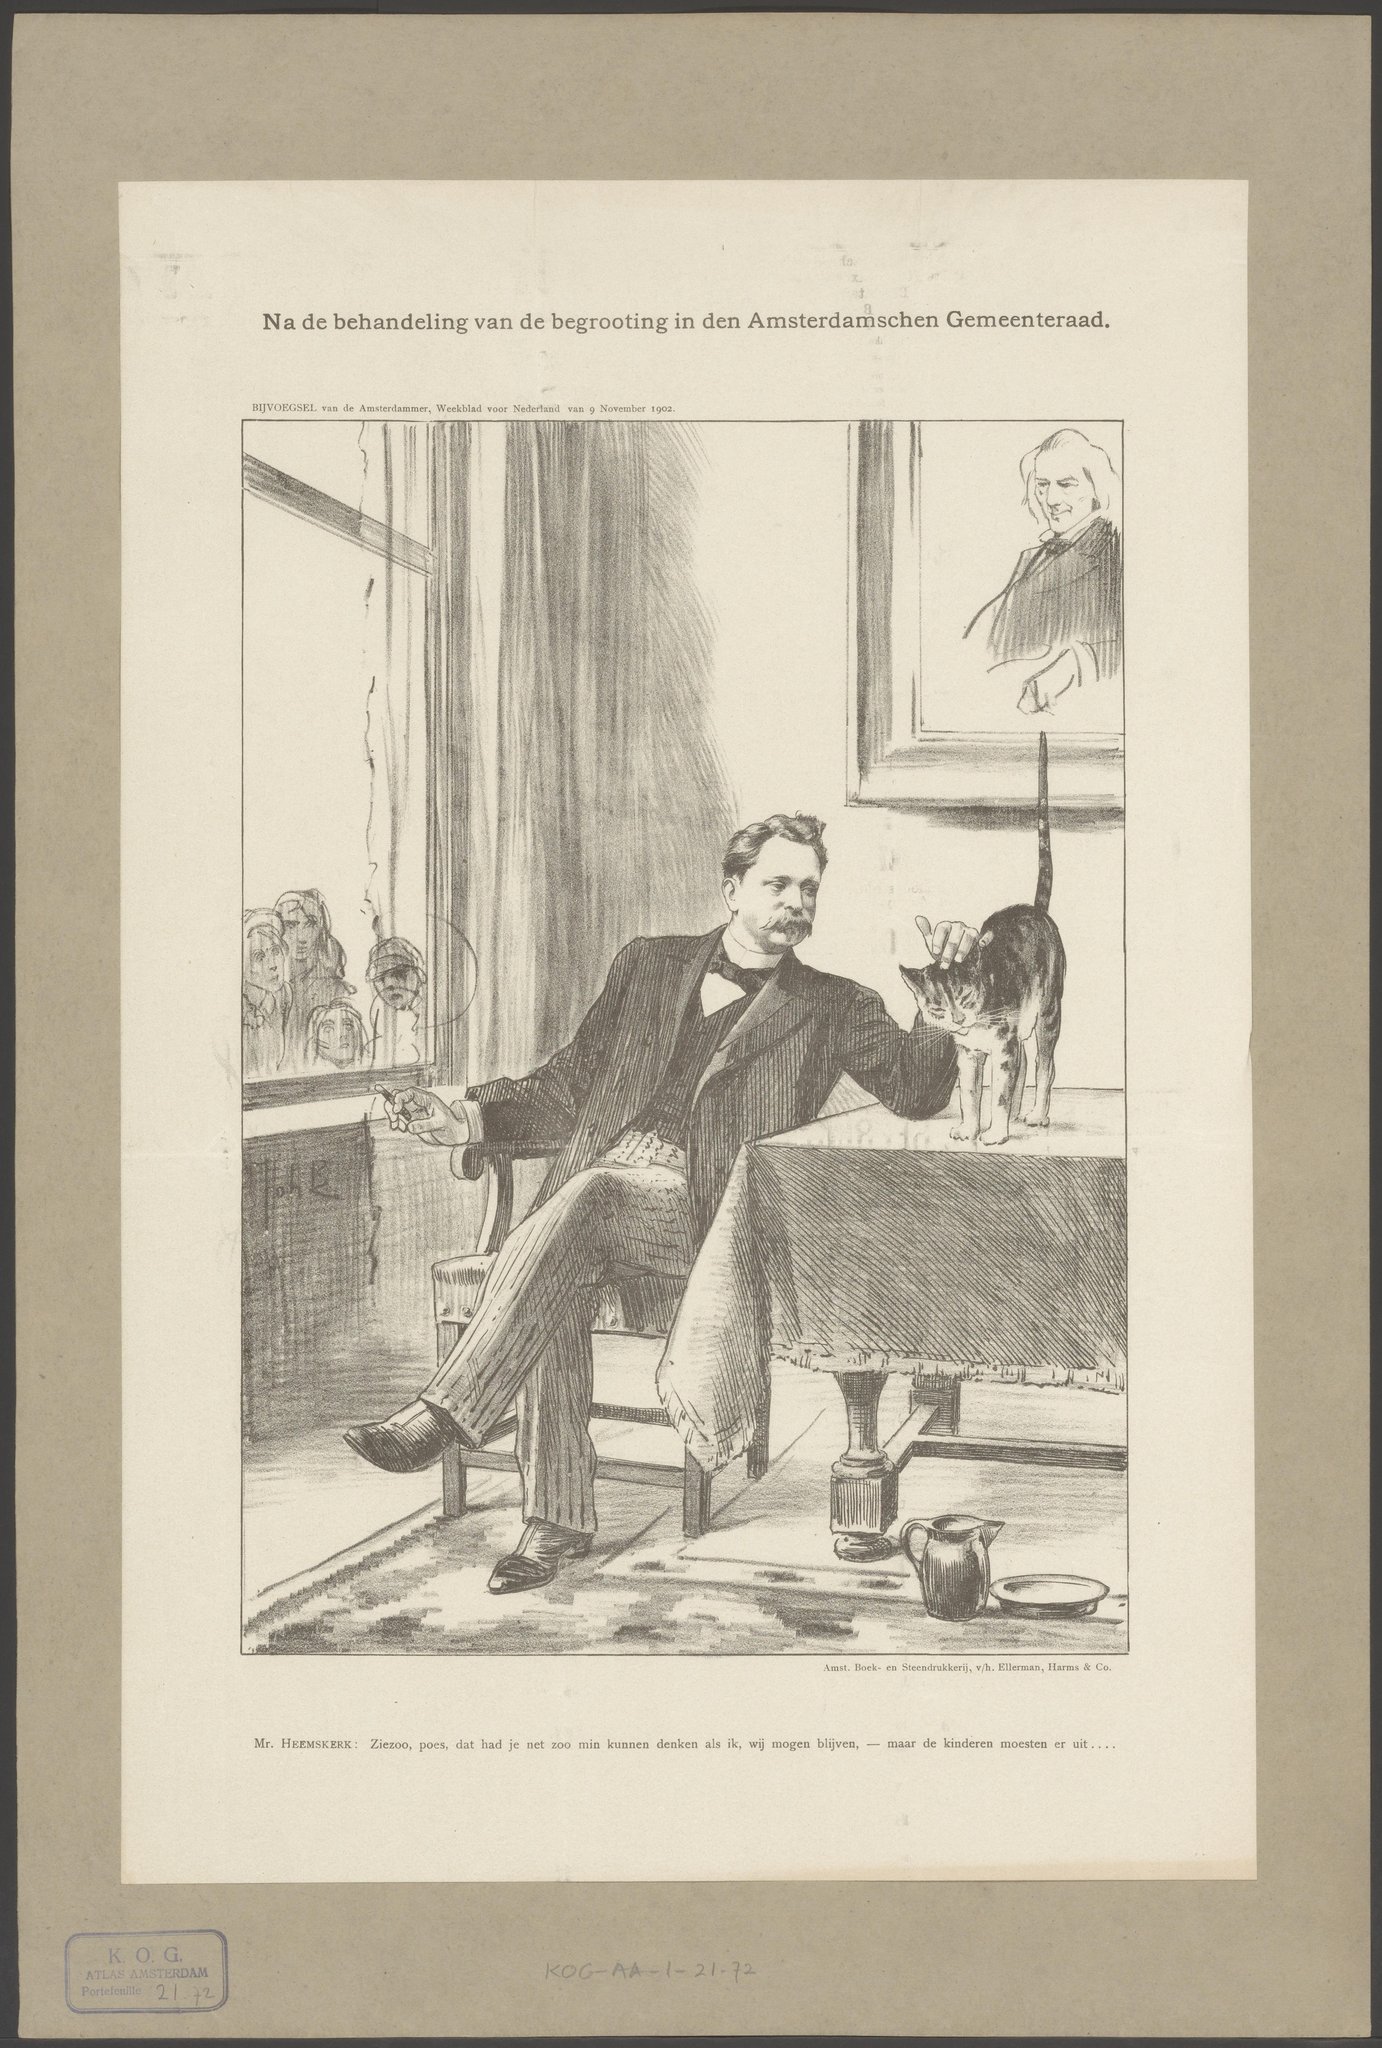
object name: cartoon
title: Theodorus Heemskerk aan een tafel gezeten met een kat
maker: johan braakensiek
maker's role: draughtsman, print maker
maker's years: 1858-1940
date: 1902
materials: paper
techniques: letterpress printing, lithograph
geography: amsterdam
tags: utrecht, politician, e.g. party leader, political caricatures and satires, amsterdam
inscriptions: collector's mark: Lugt 1641b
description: Gepubliceerd als bijvoegsel bij 'De Amsterdammer' van 9 november 1902.